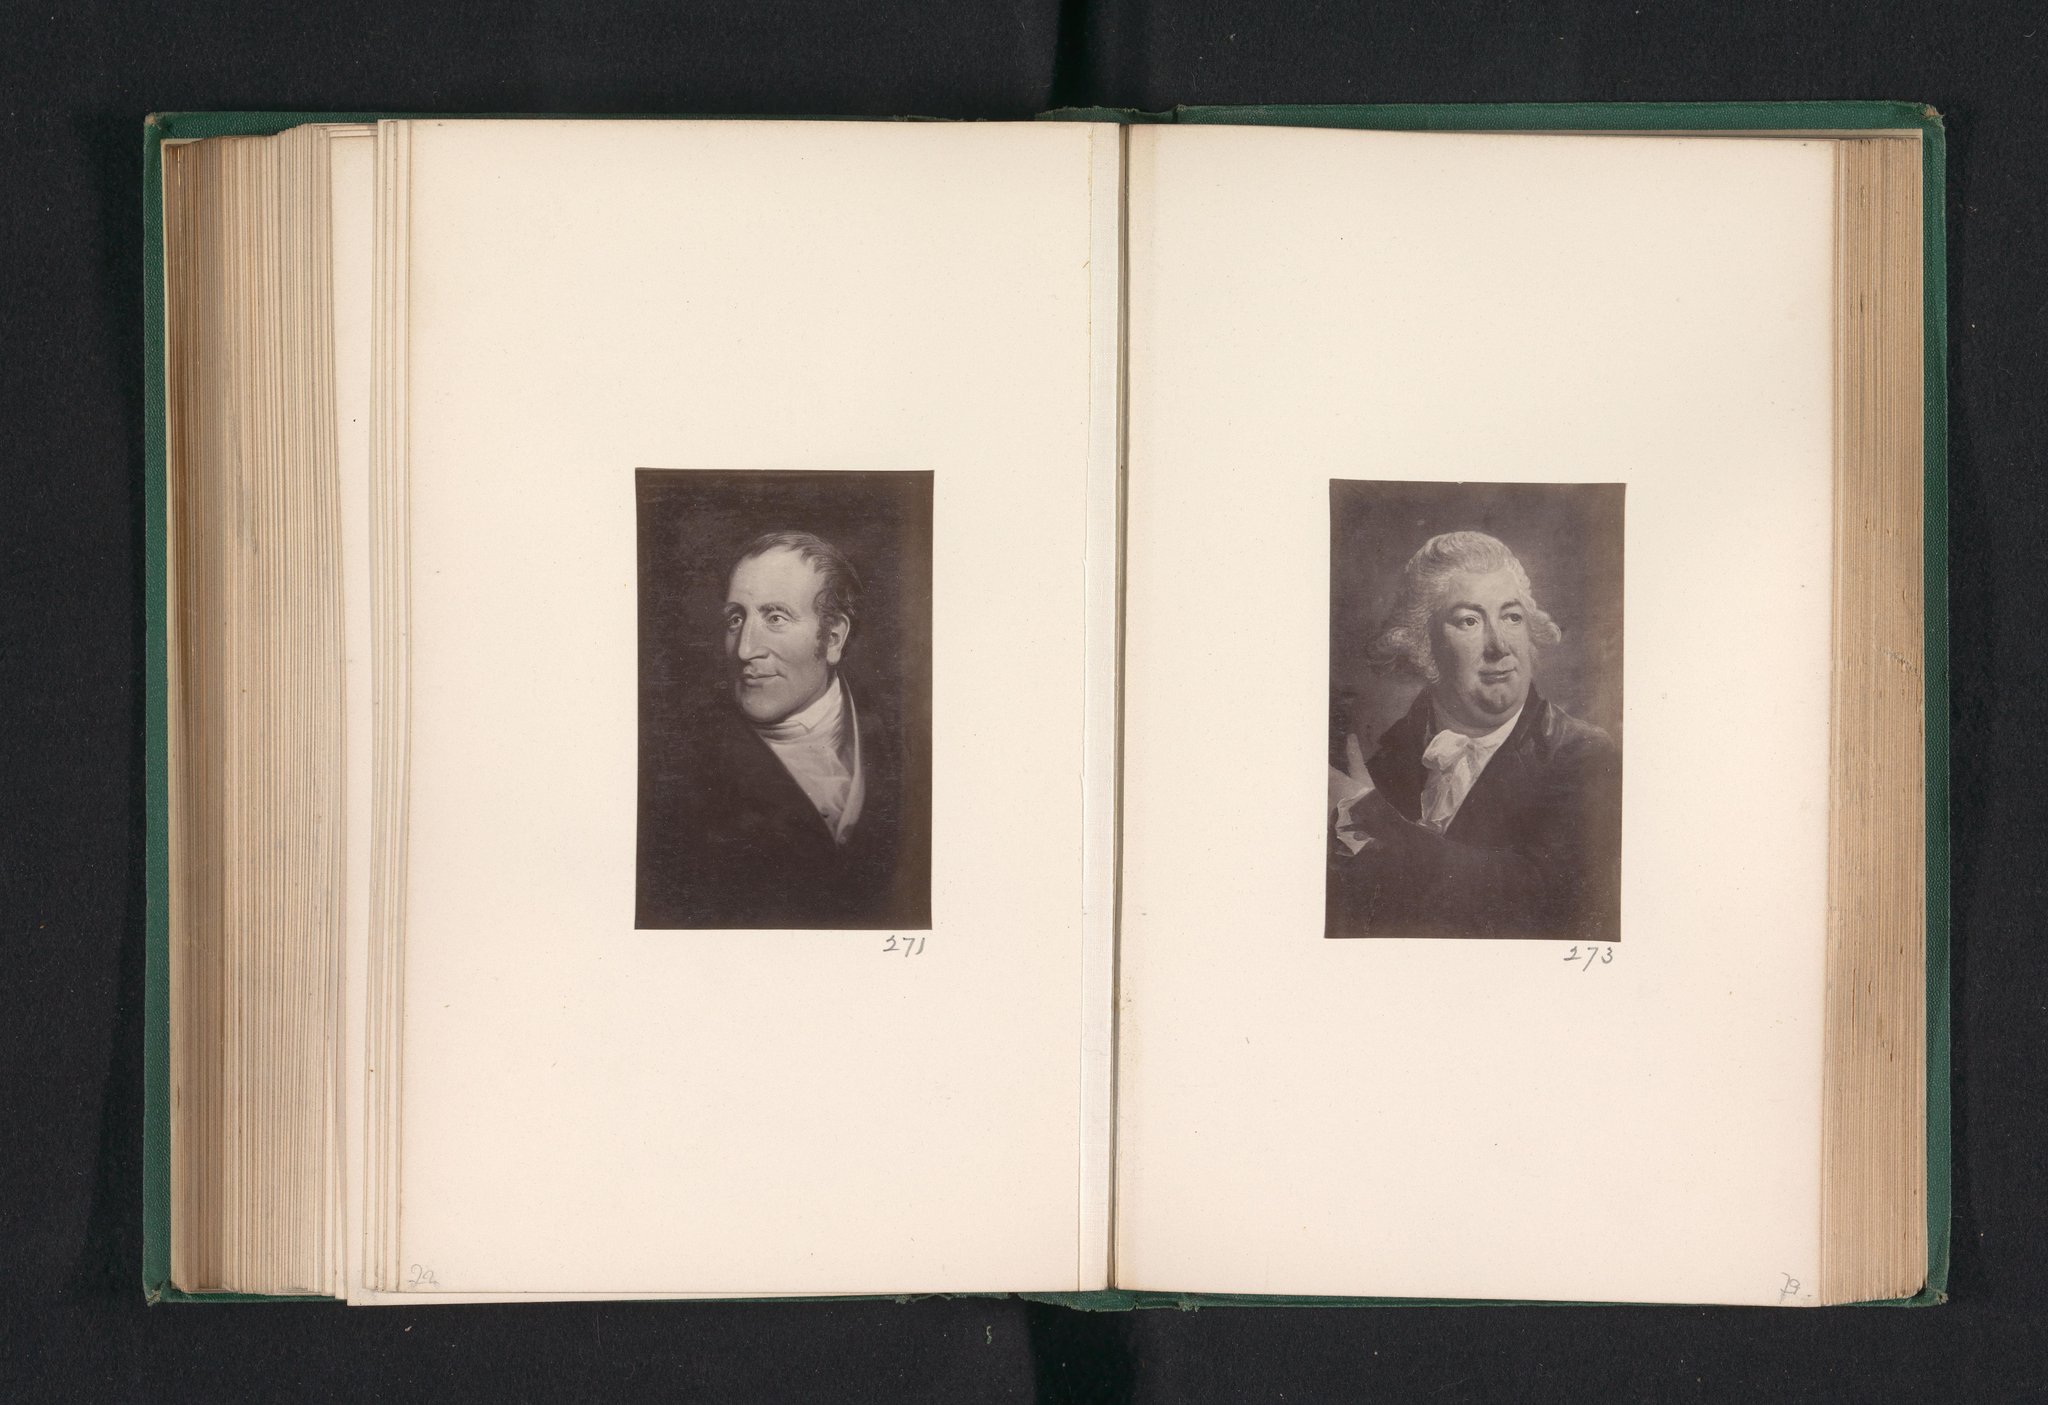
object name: photograph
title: Fotoreproductie van een schilderij, voorstellende een portret van Robert Cunningham C. Graham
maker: thomas annan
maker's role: fotograaf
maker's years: 1829-1887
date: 1863-1868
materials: photographic support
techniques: albumen print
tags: historical persons (portraits and scenes from the life) (+ (full) bust portrait)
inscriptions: number: ‘273’